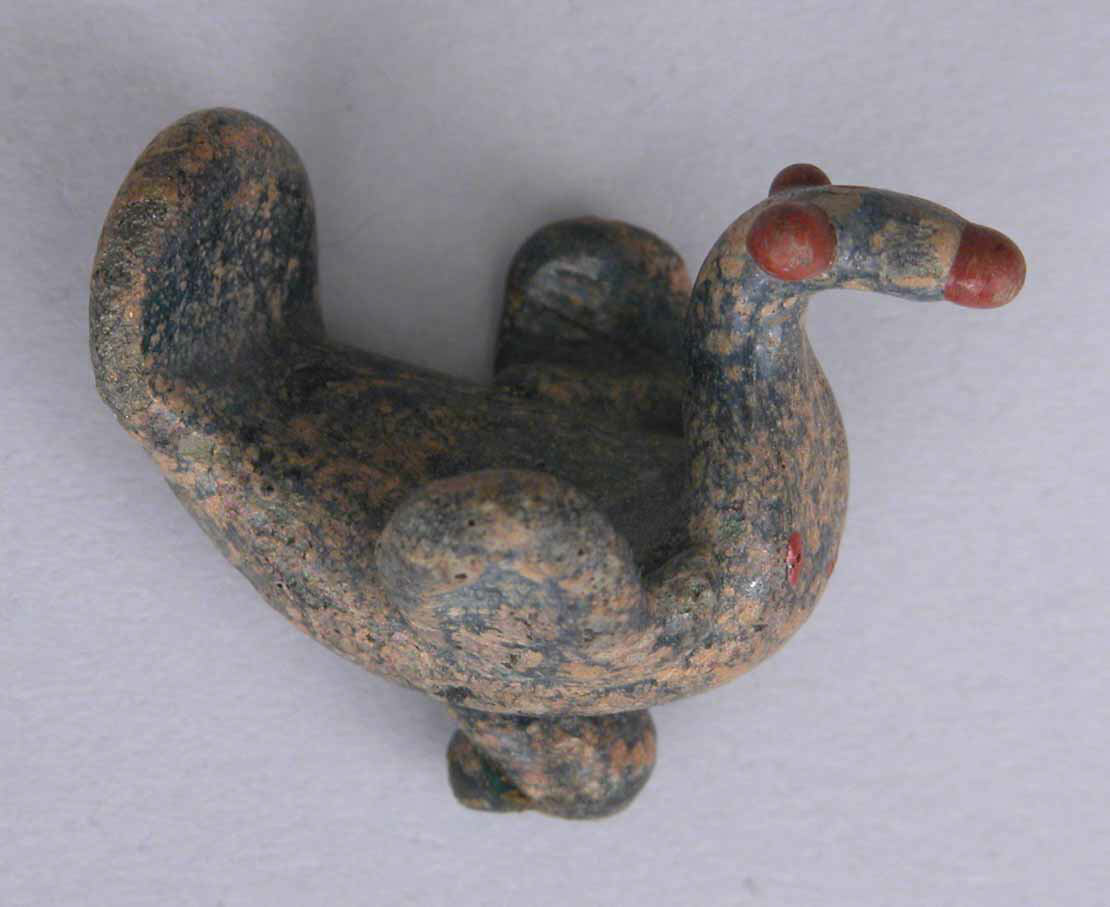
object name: figure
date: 701-900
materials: glass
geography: egypt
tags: birds